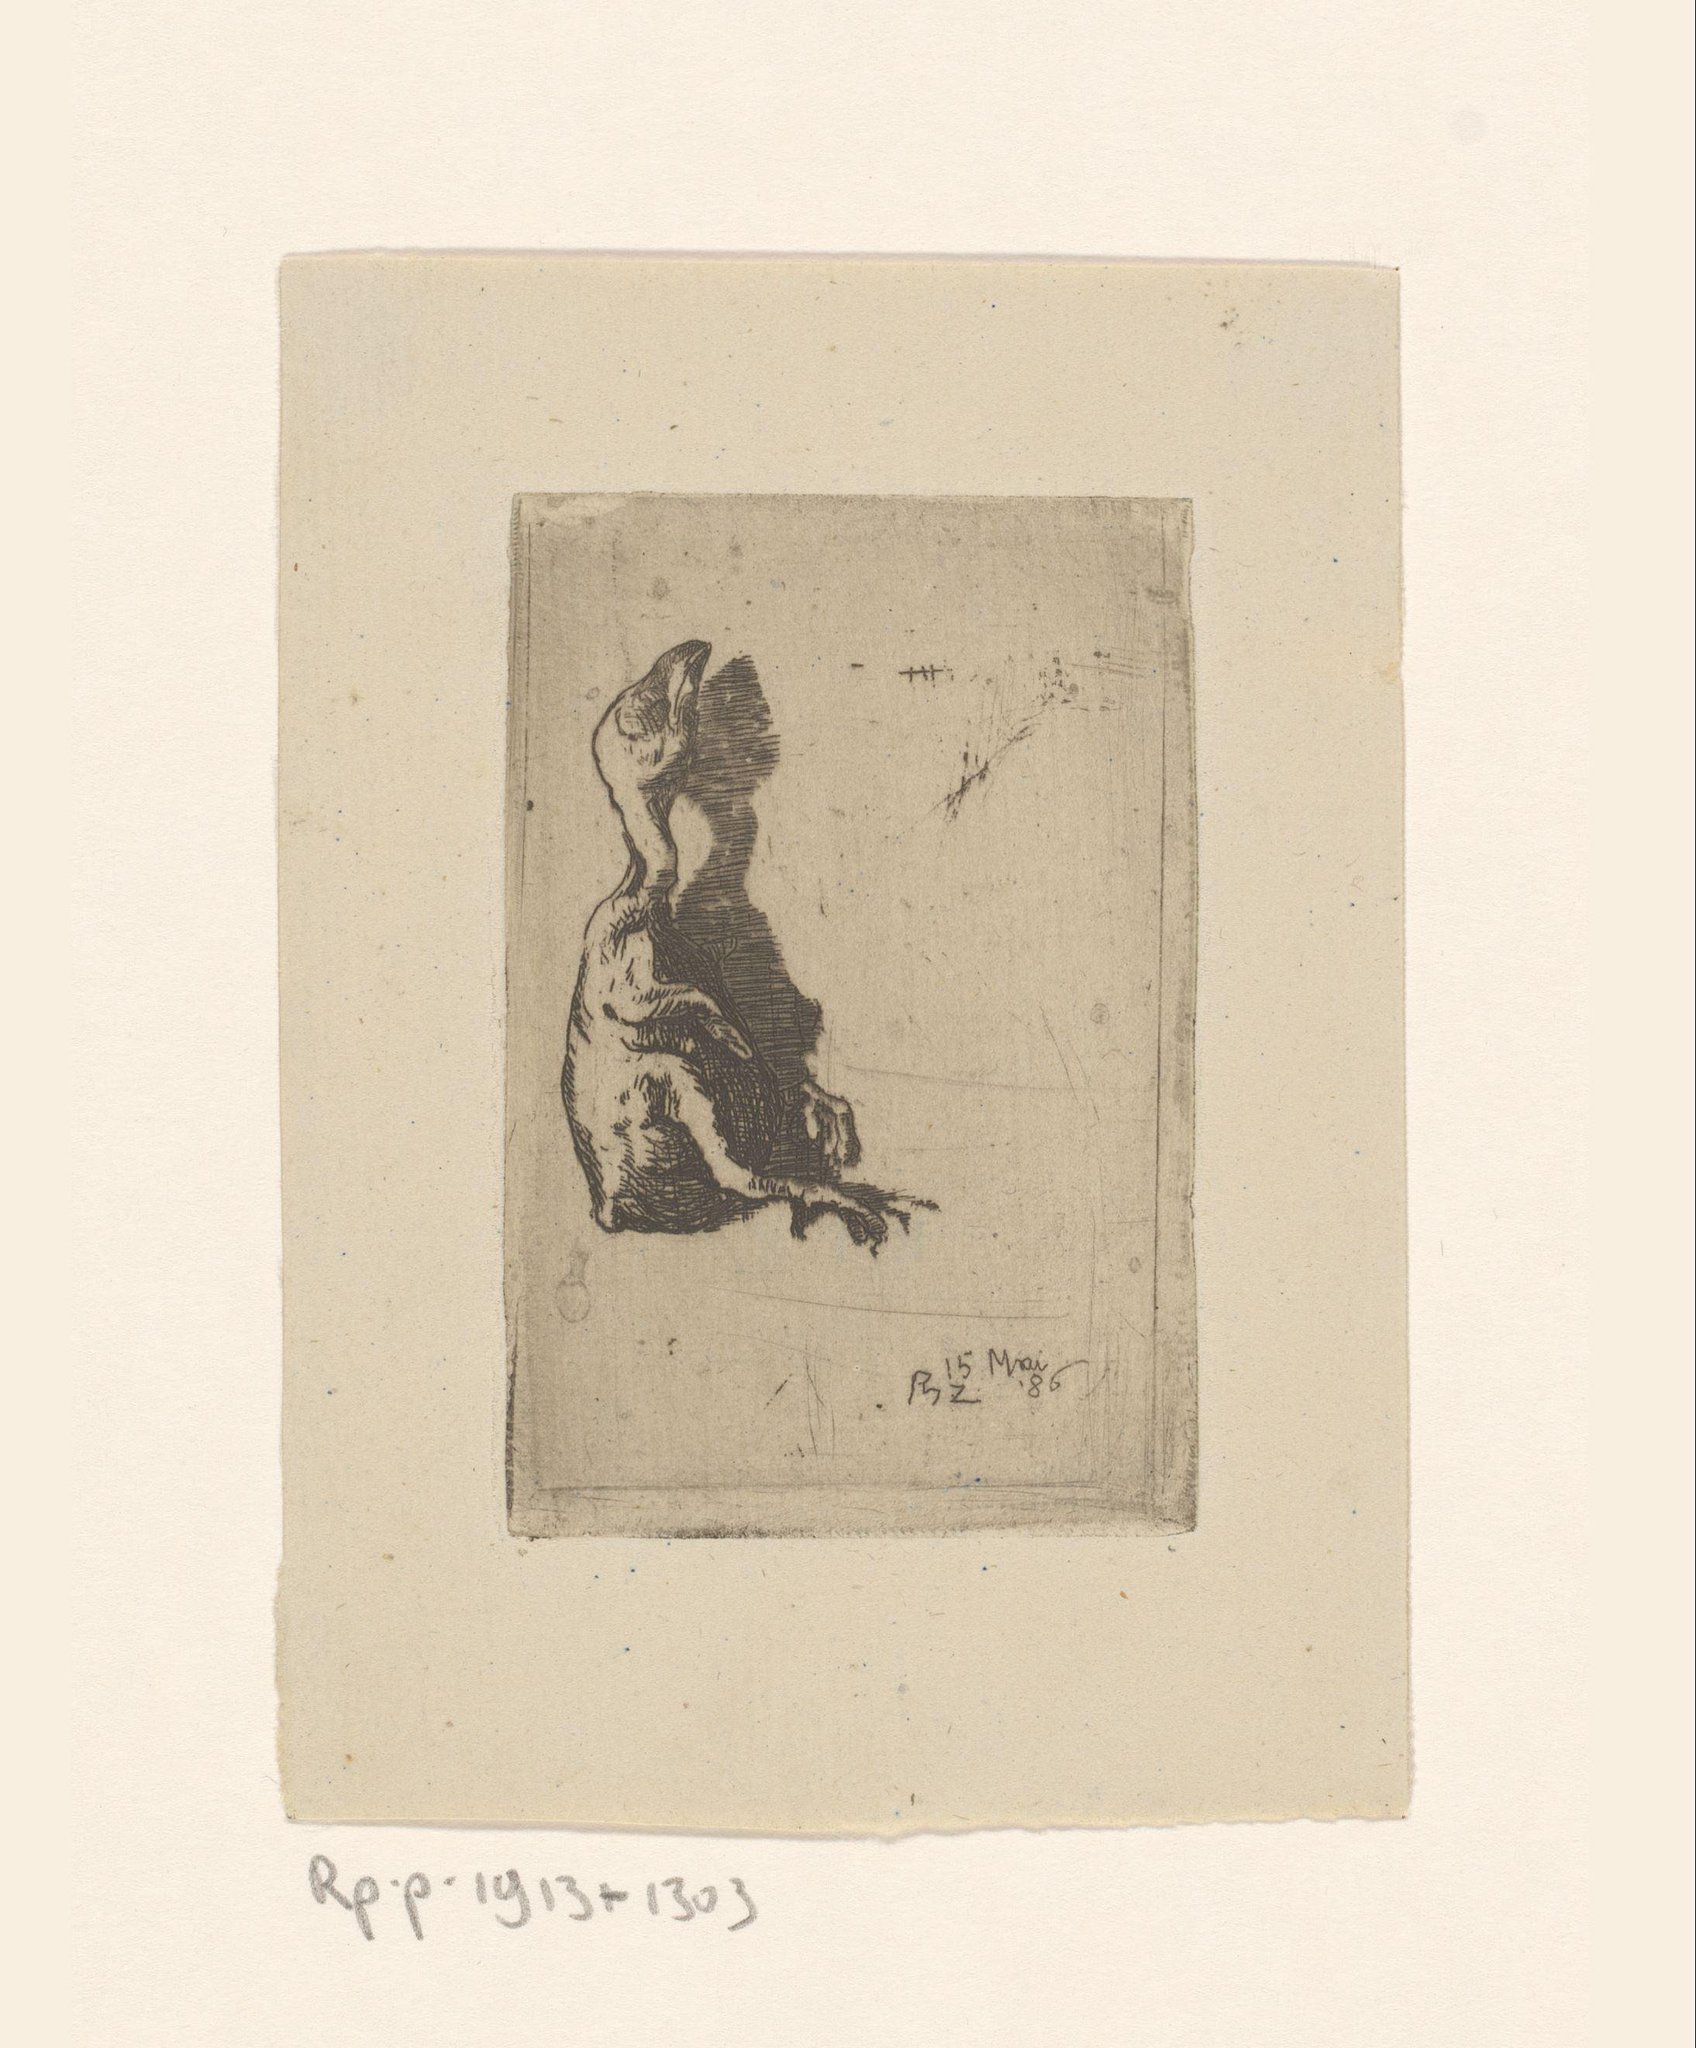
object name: print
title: Kleine dode vogel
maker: philip zilcken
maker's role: draughtsman, painter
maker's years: 1857-1930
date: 1886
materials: paper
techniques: etching, intaglio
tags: birds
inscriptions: collector's mark: Lugt 2233